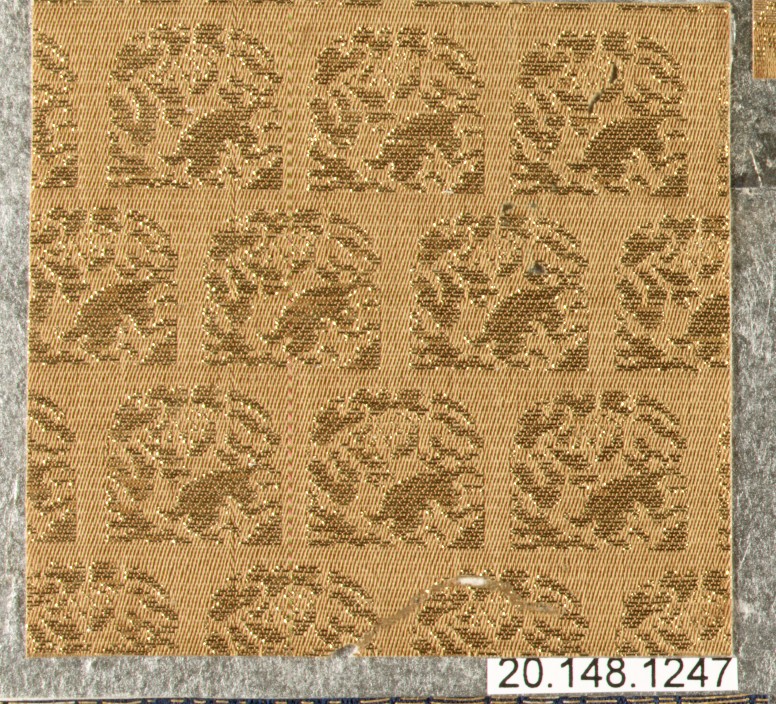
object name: piece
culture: japanese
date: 1801-1900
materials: silk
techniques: compound weave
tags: animals